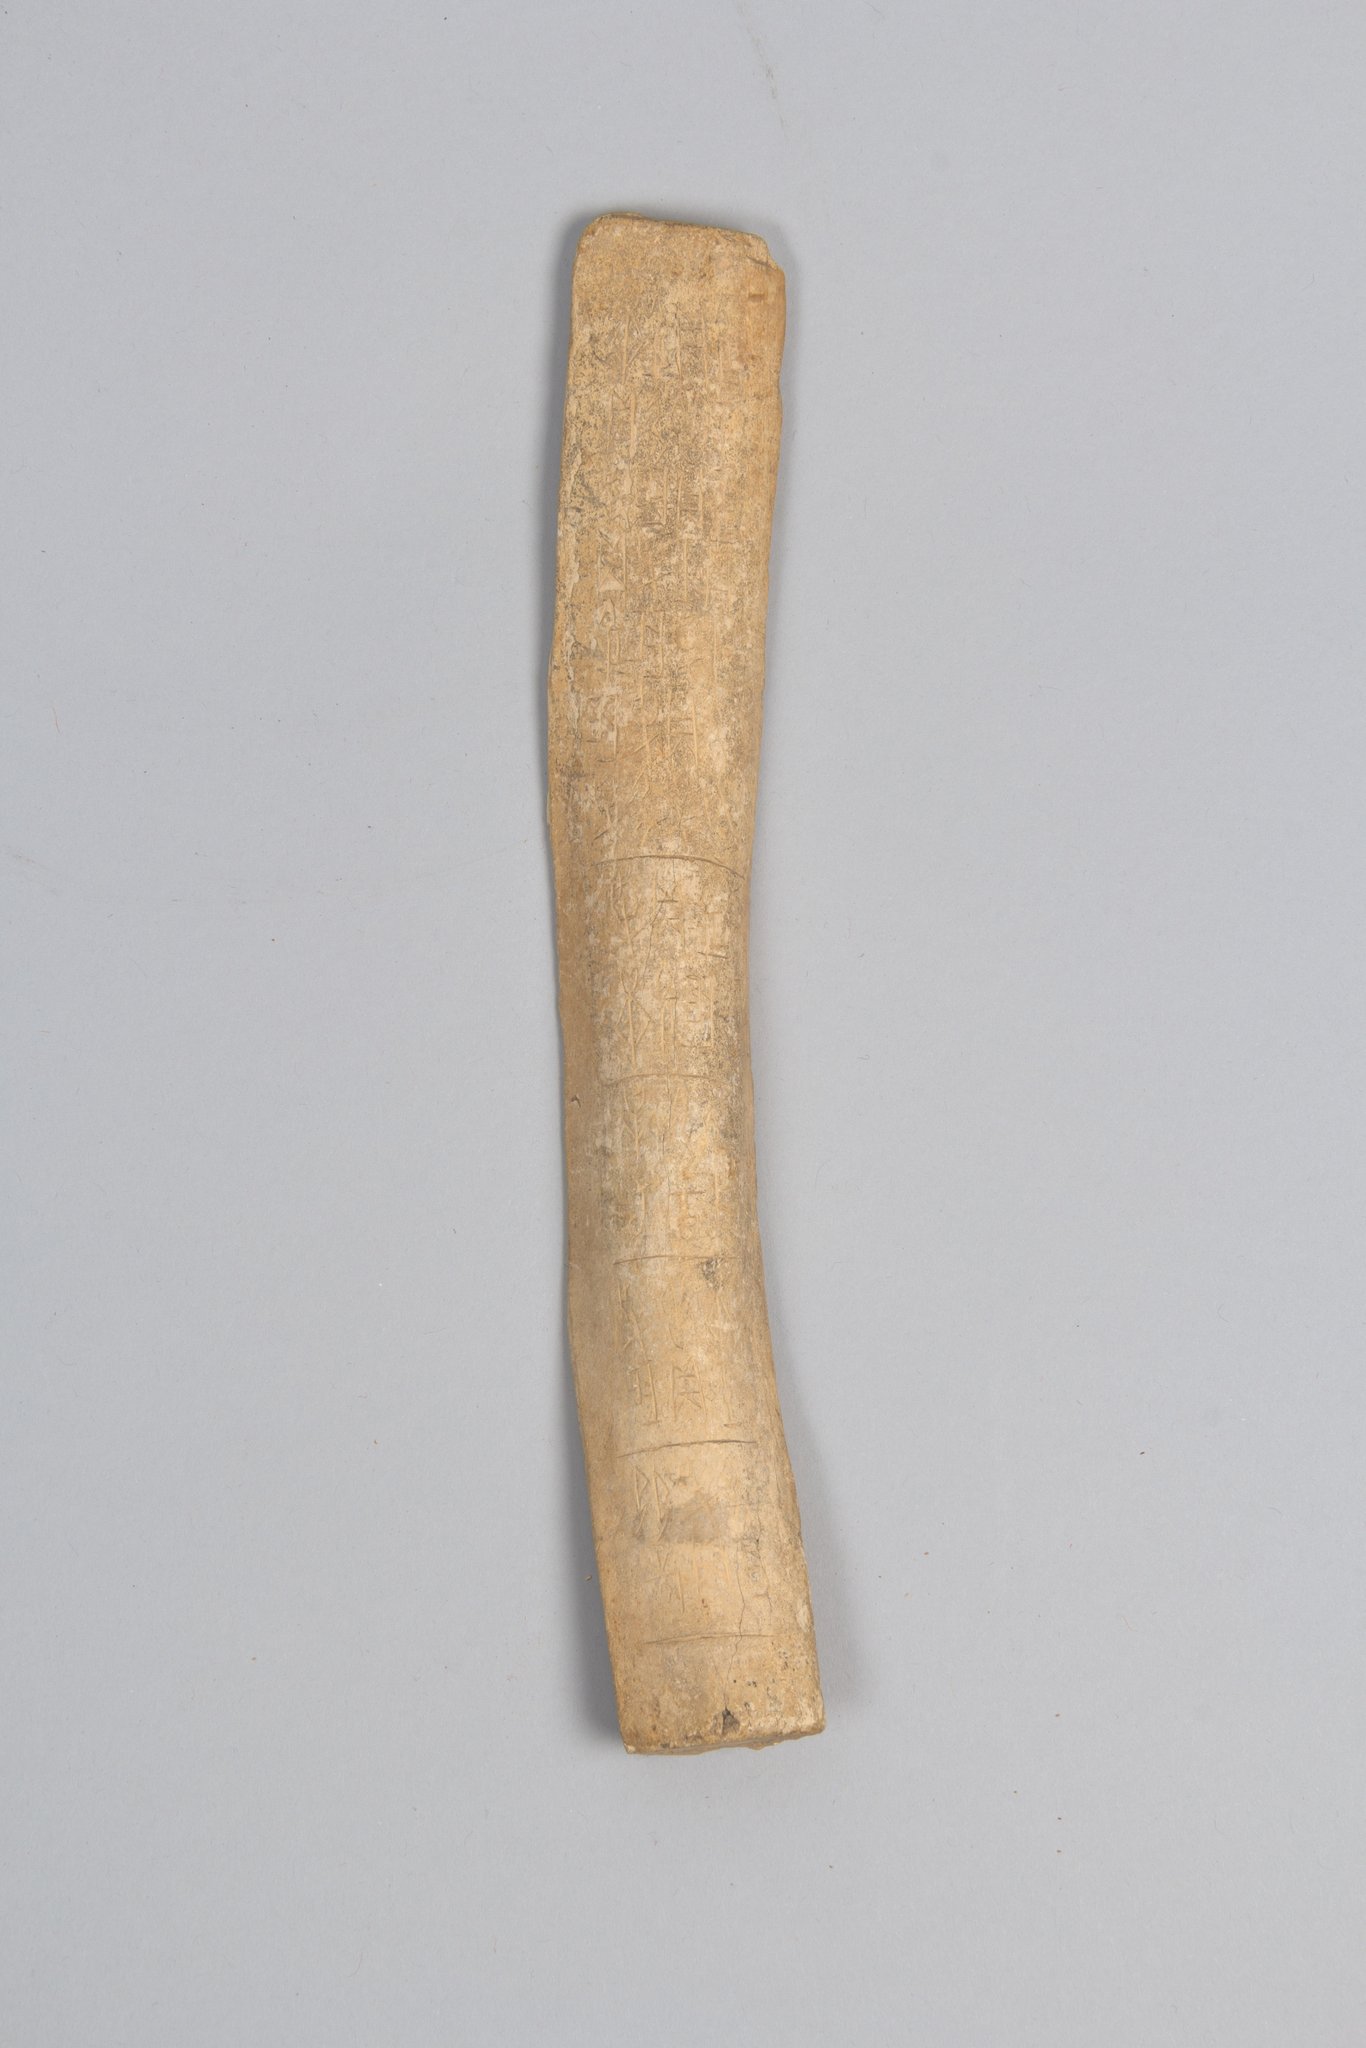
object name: oracle bone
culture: chinese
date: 1600-1046 BCE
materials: bone